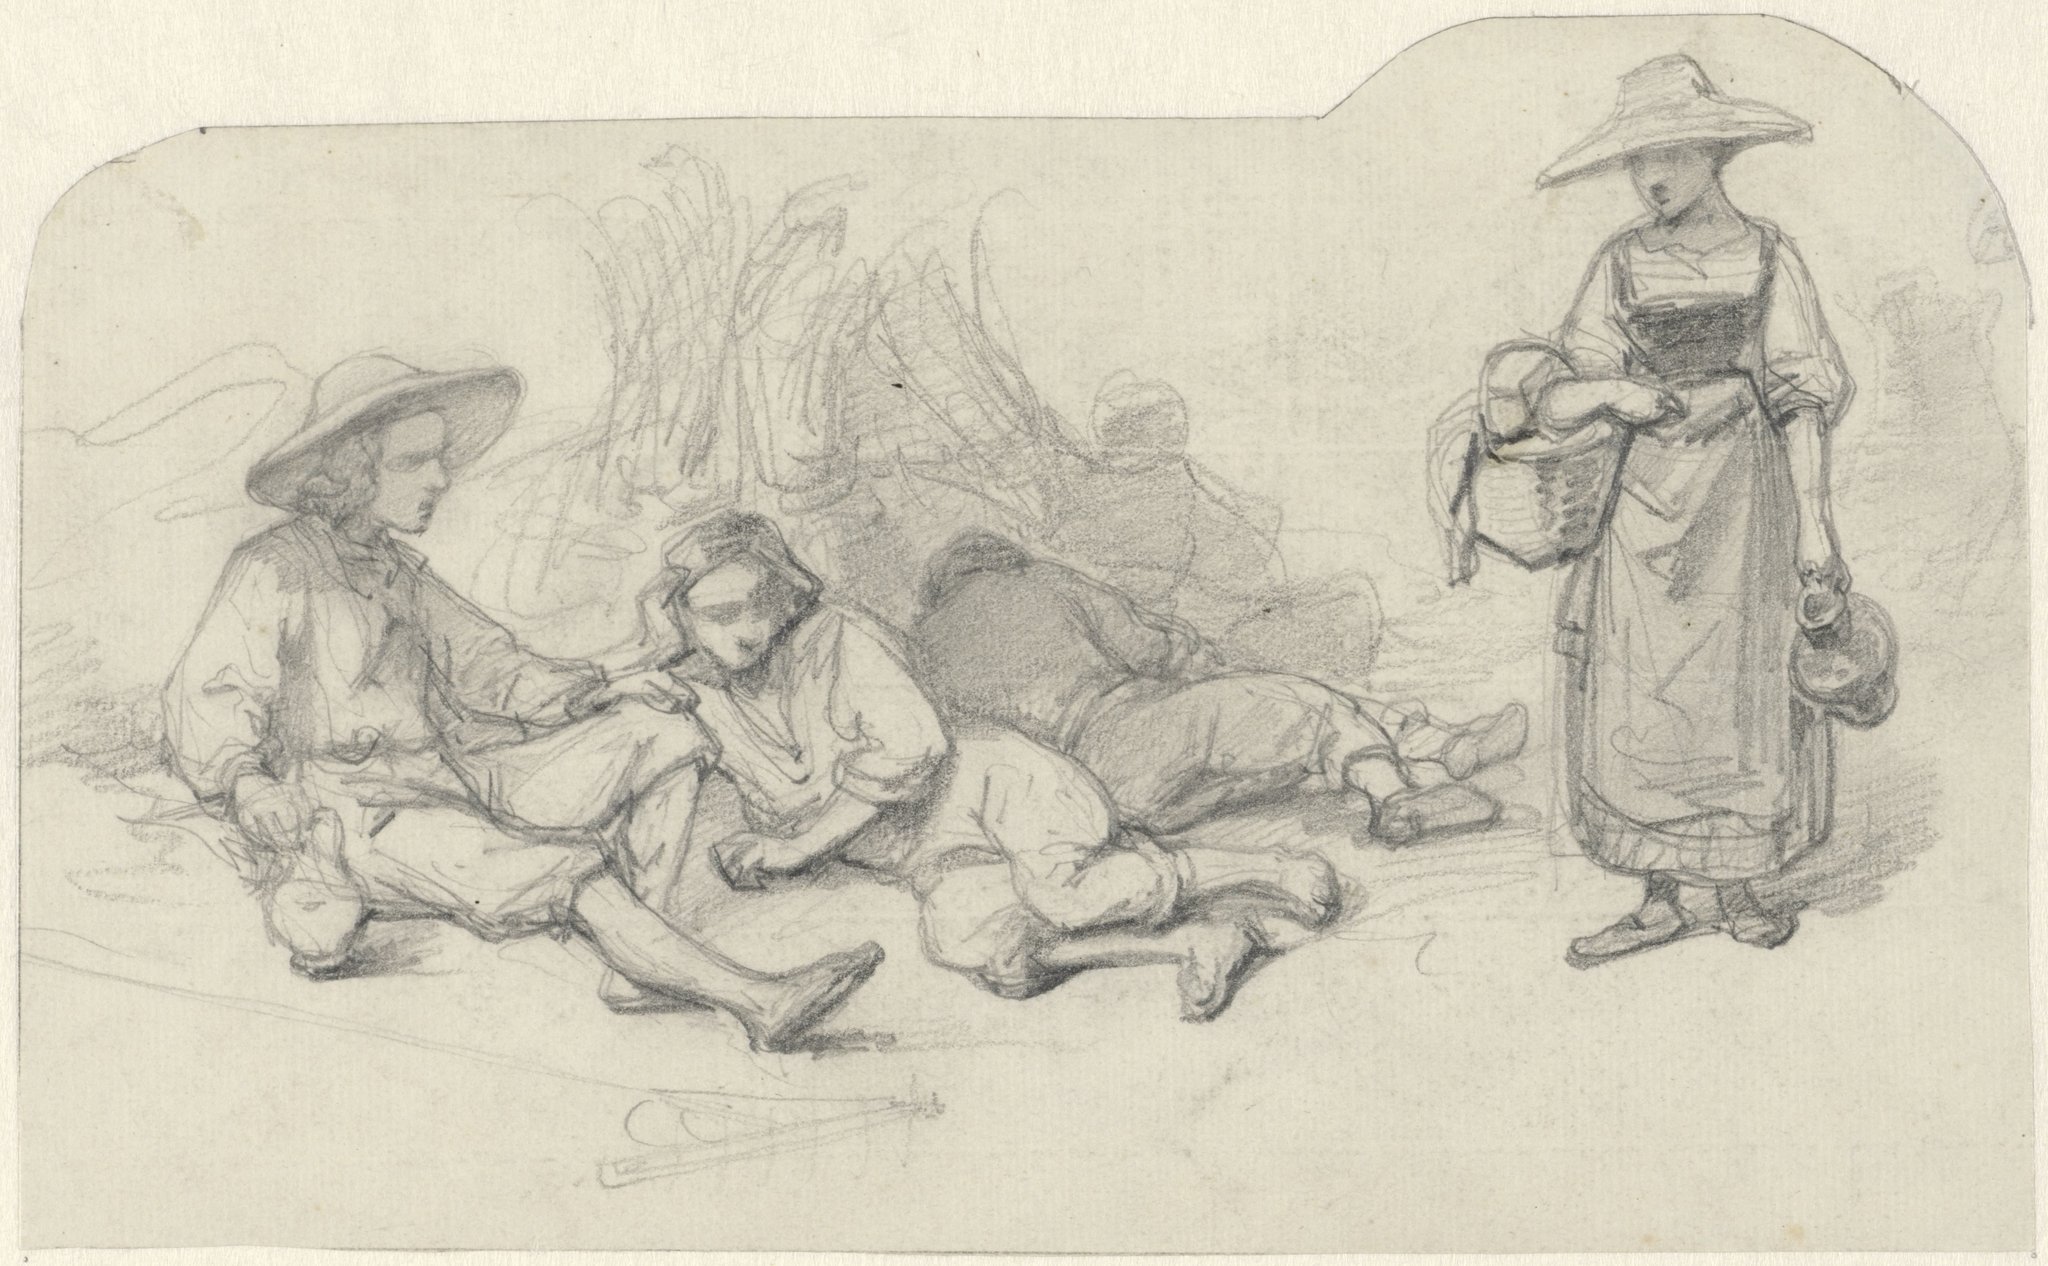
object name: drawing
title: Rustende maaiers en vrouw met eten en drinken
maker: willem pieter hoevenaar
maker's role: draughtsman, painter, print maker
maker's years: 1808-1863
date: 1818-1863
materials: paper, pencil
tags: rest during harvest (eating, dancing, making love, etc.)